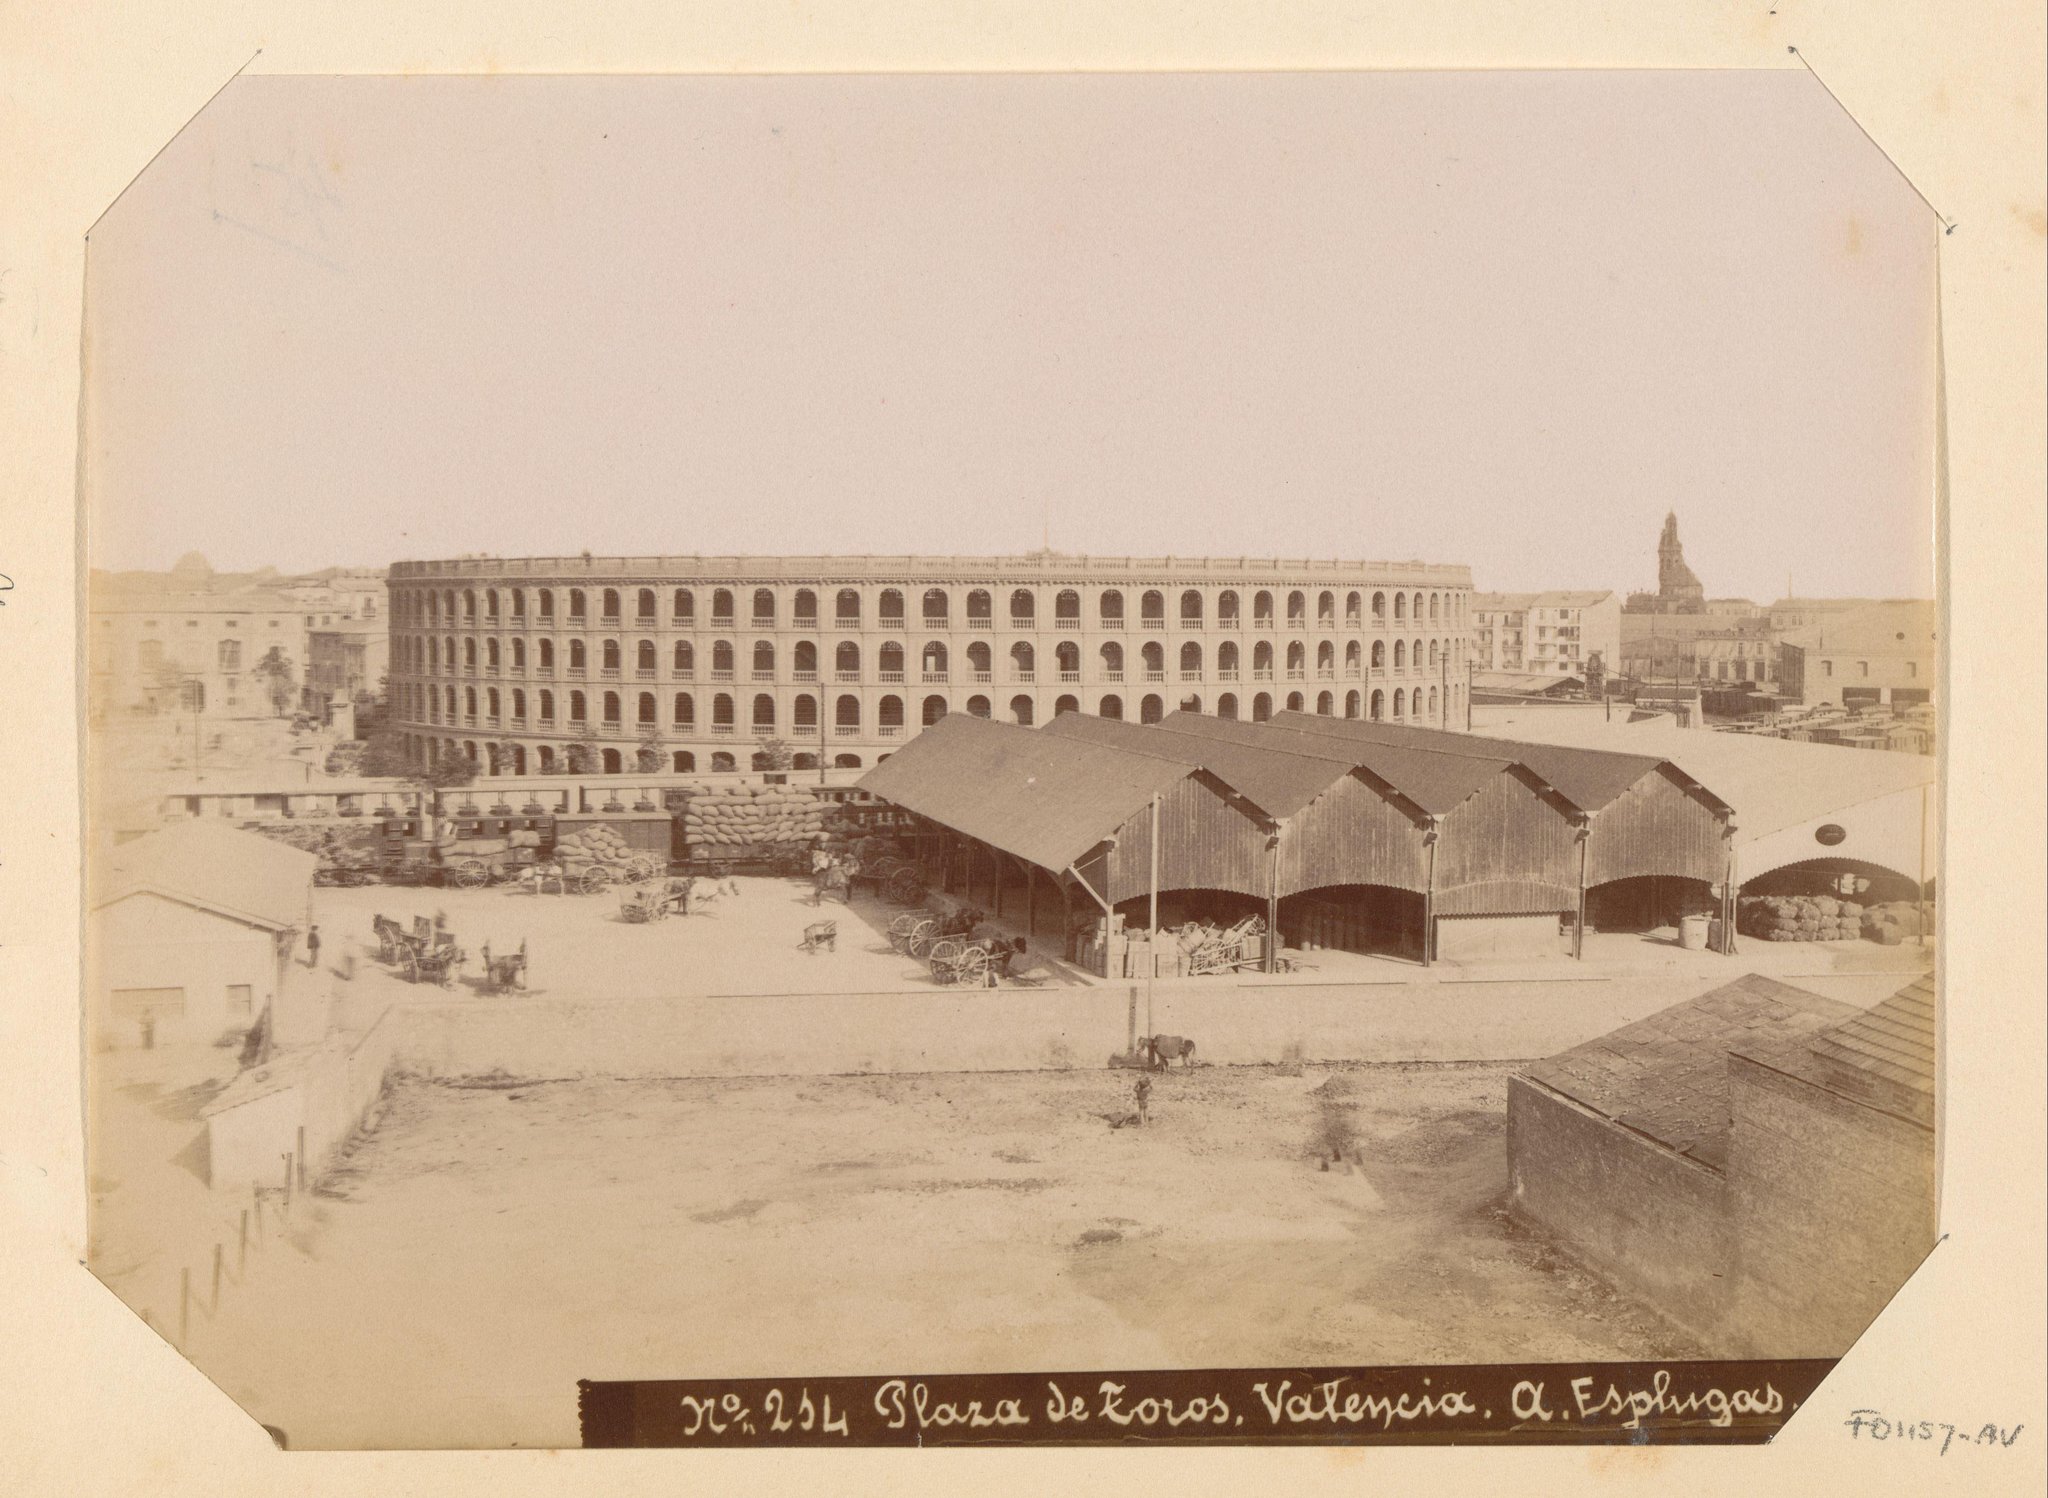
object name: photograph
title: Plaza de toros de Valencia te Valencia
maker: antoni esplugas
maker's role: fotograaf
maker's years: 1852-1929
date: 1888-1892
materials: photographic support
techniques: albumen print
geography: valencia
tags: other dwelling types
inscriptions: annotation: ‘Valencia - Marktplaats en PLaza de Toros’, number: ‘214’